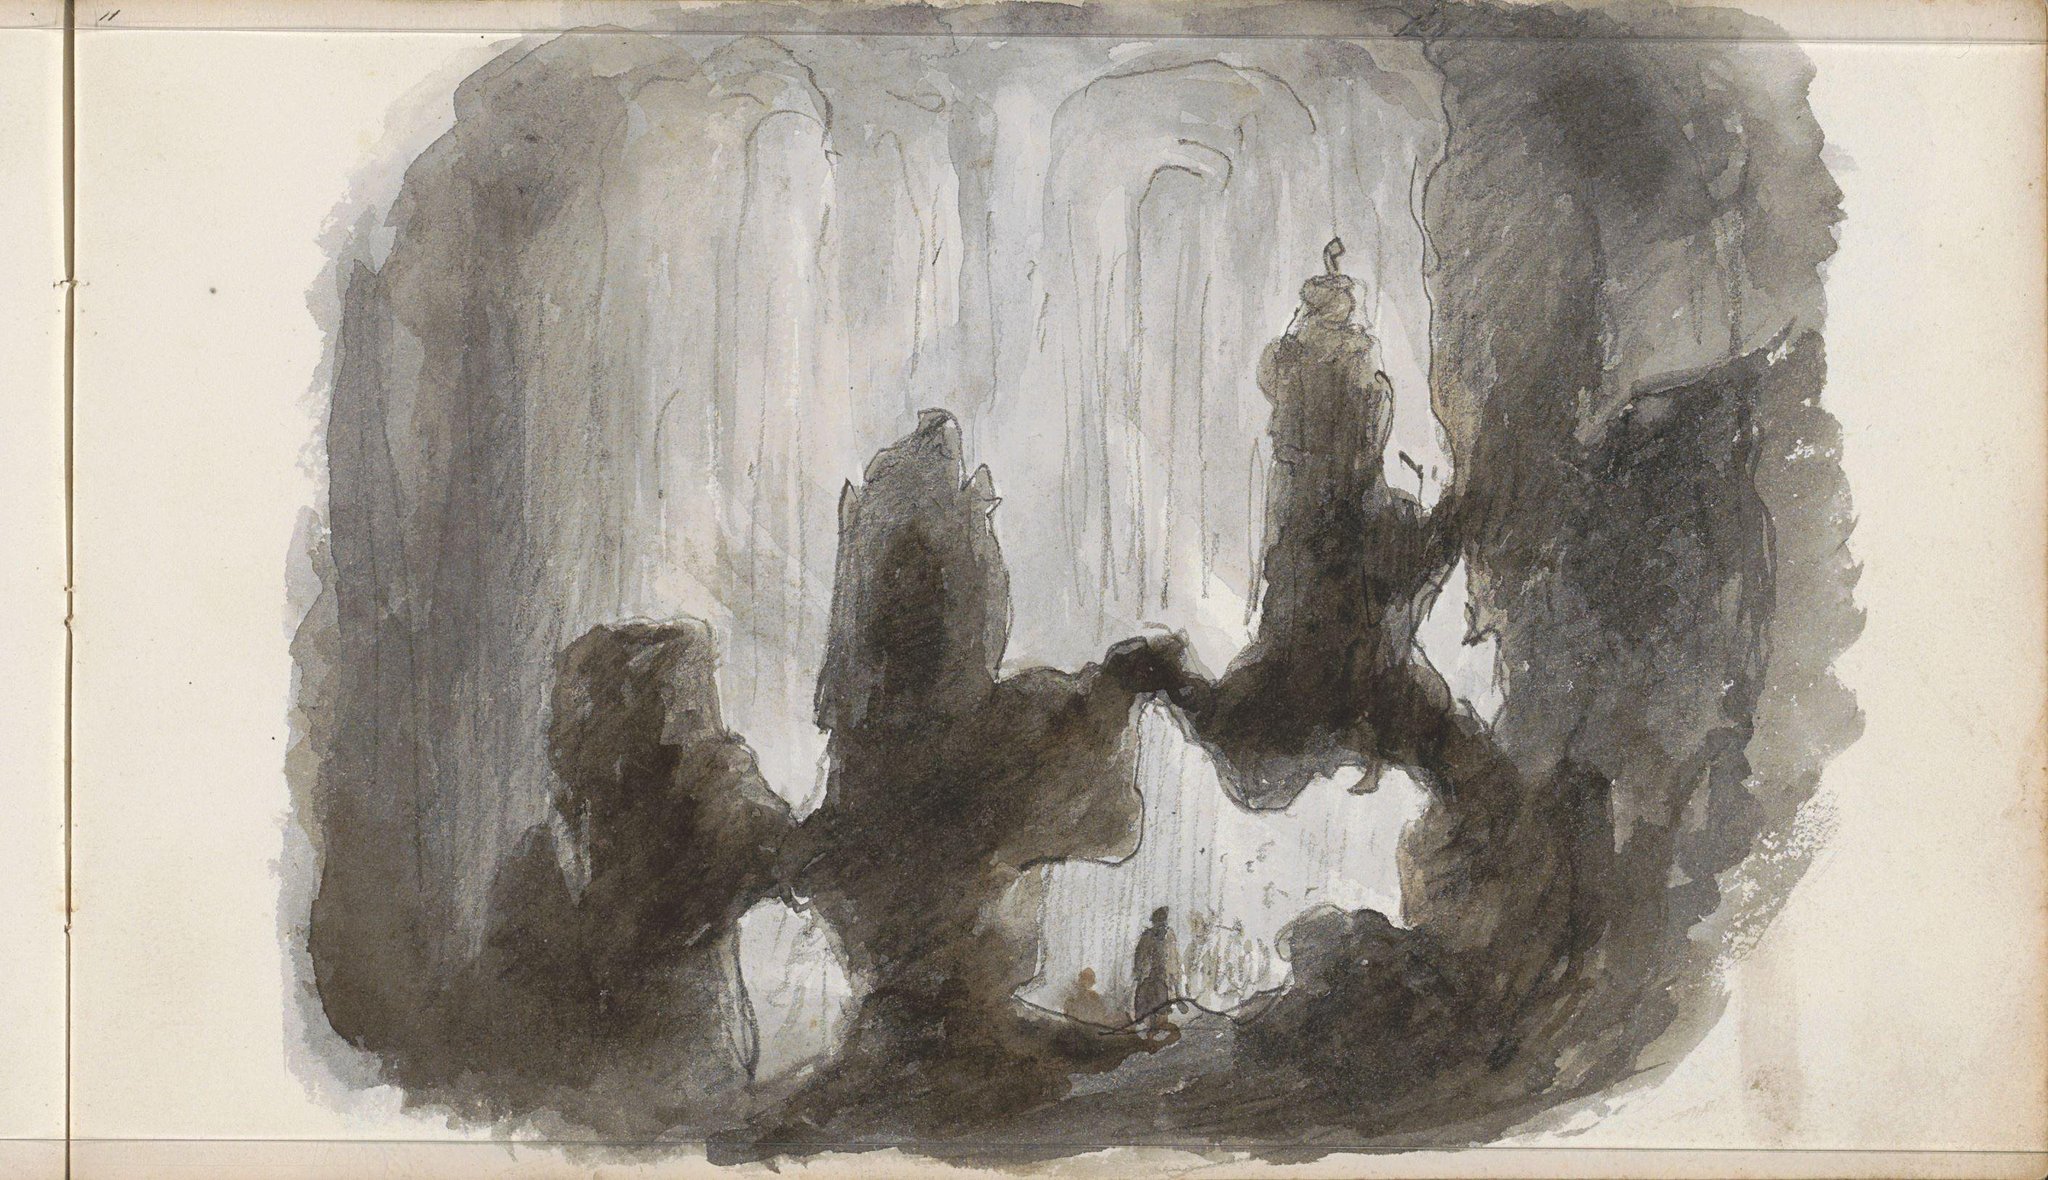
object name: sketchbook leaf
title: Druipsteengrot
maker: petrus johannes schotel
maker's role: draughtsman, painter, print maker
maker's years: 1808-1865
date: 1841-1865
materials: paper, pencil, watercolor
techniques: brush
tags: stalactitic cave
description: Pagina 11 uit een schetsboek met 80 pagina's.